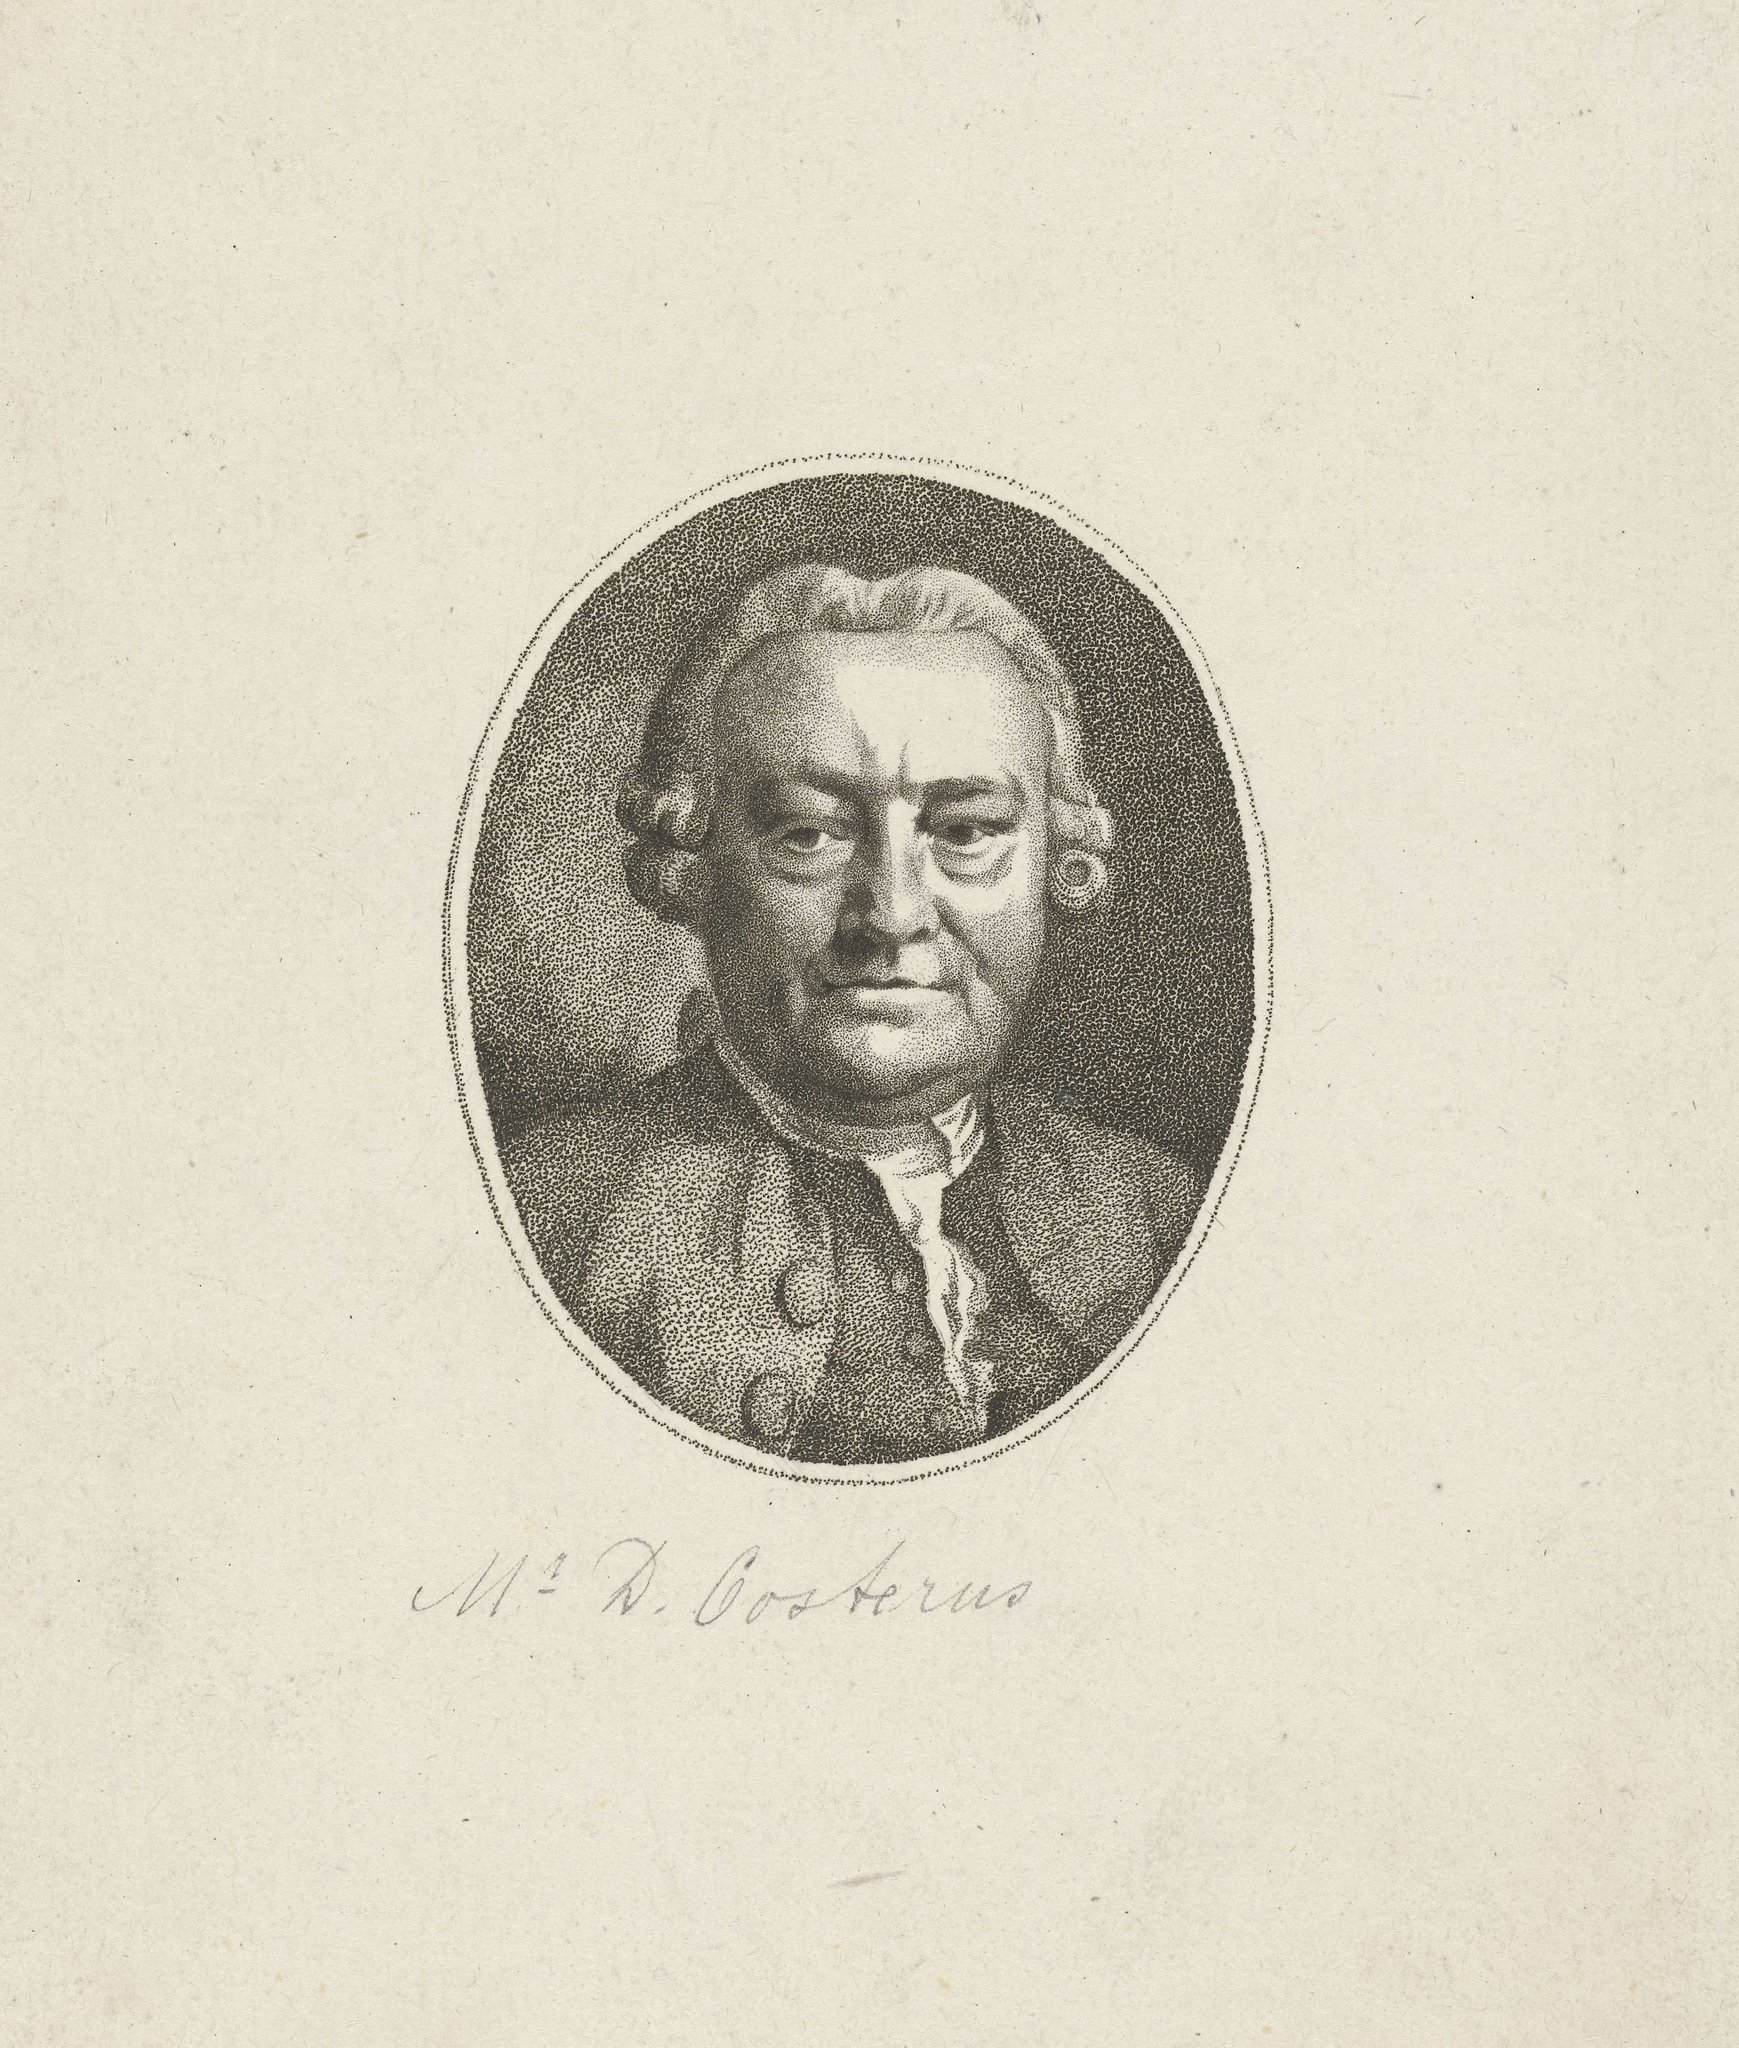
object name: print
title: Portret van Dominicus Costerus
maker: jan kobell (i)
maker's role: draughtsman, print maker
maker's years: 1756-1833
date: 1766-1833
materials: paper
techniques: engraving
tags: dominicus costerus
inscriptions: collector's mark: Lugt 2228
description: Portretbuste van Dominicus Costerus, schout en baljuw in Woerden en schrijver.